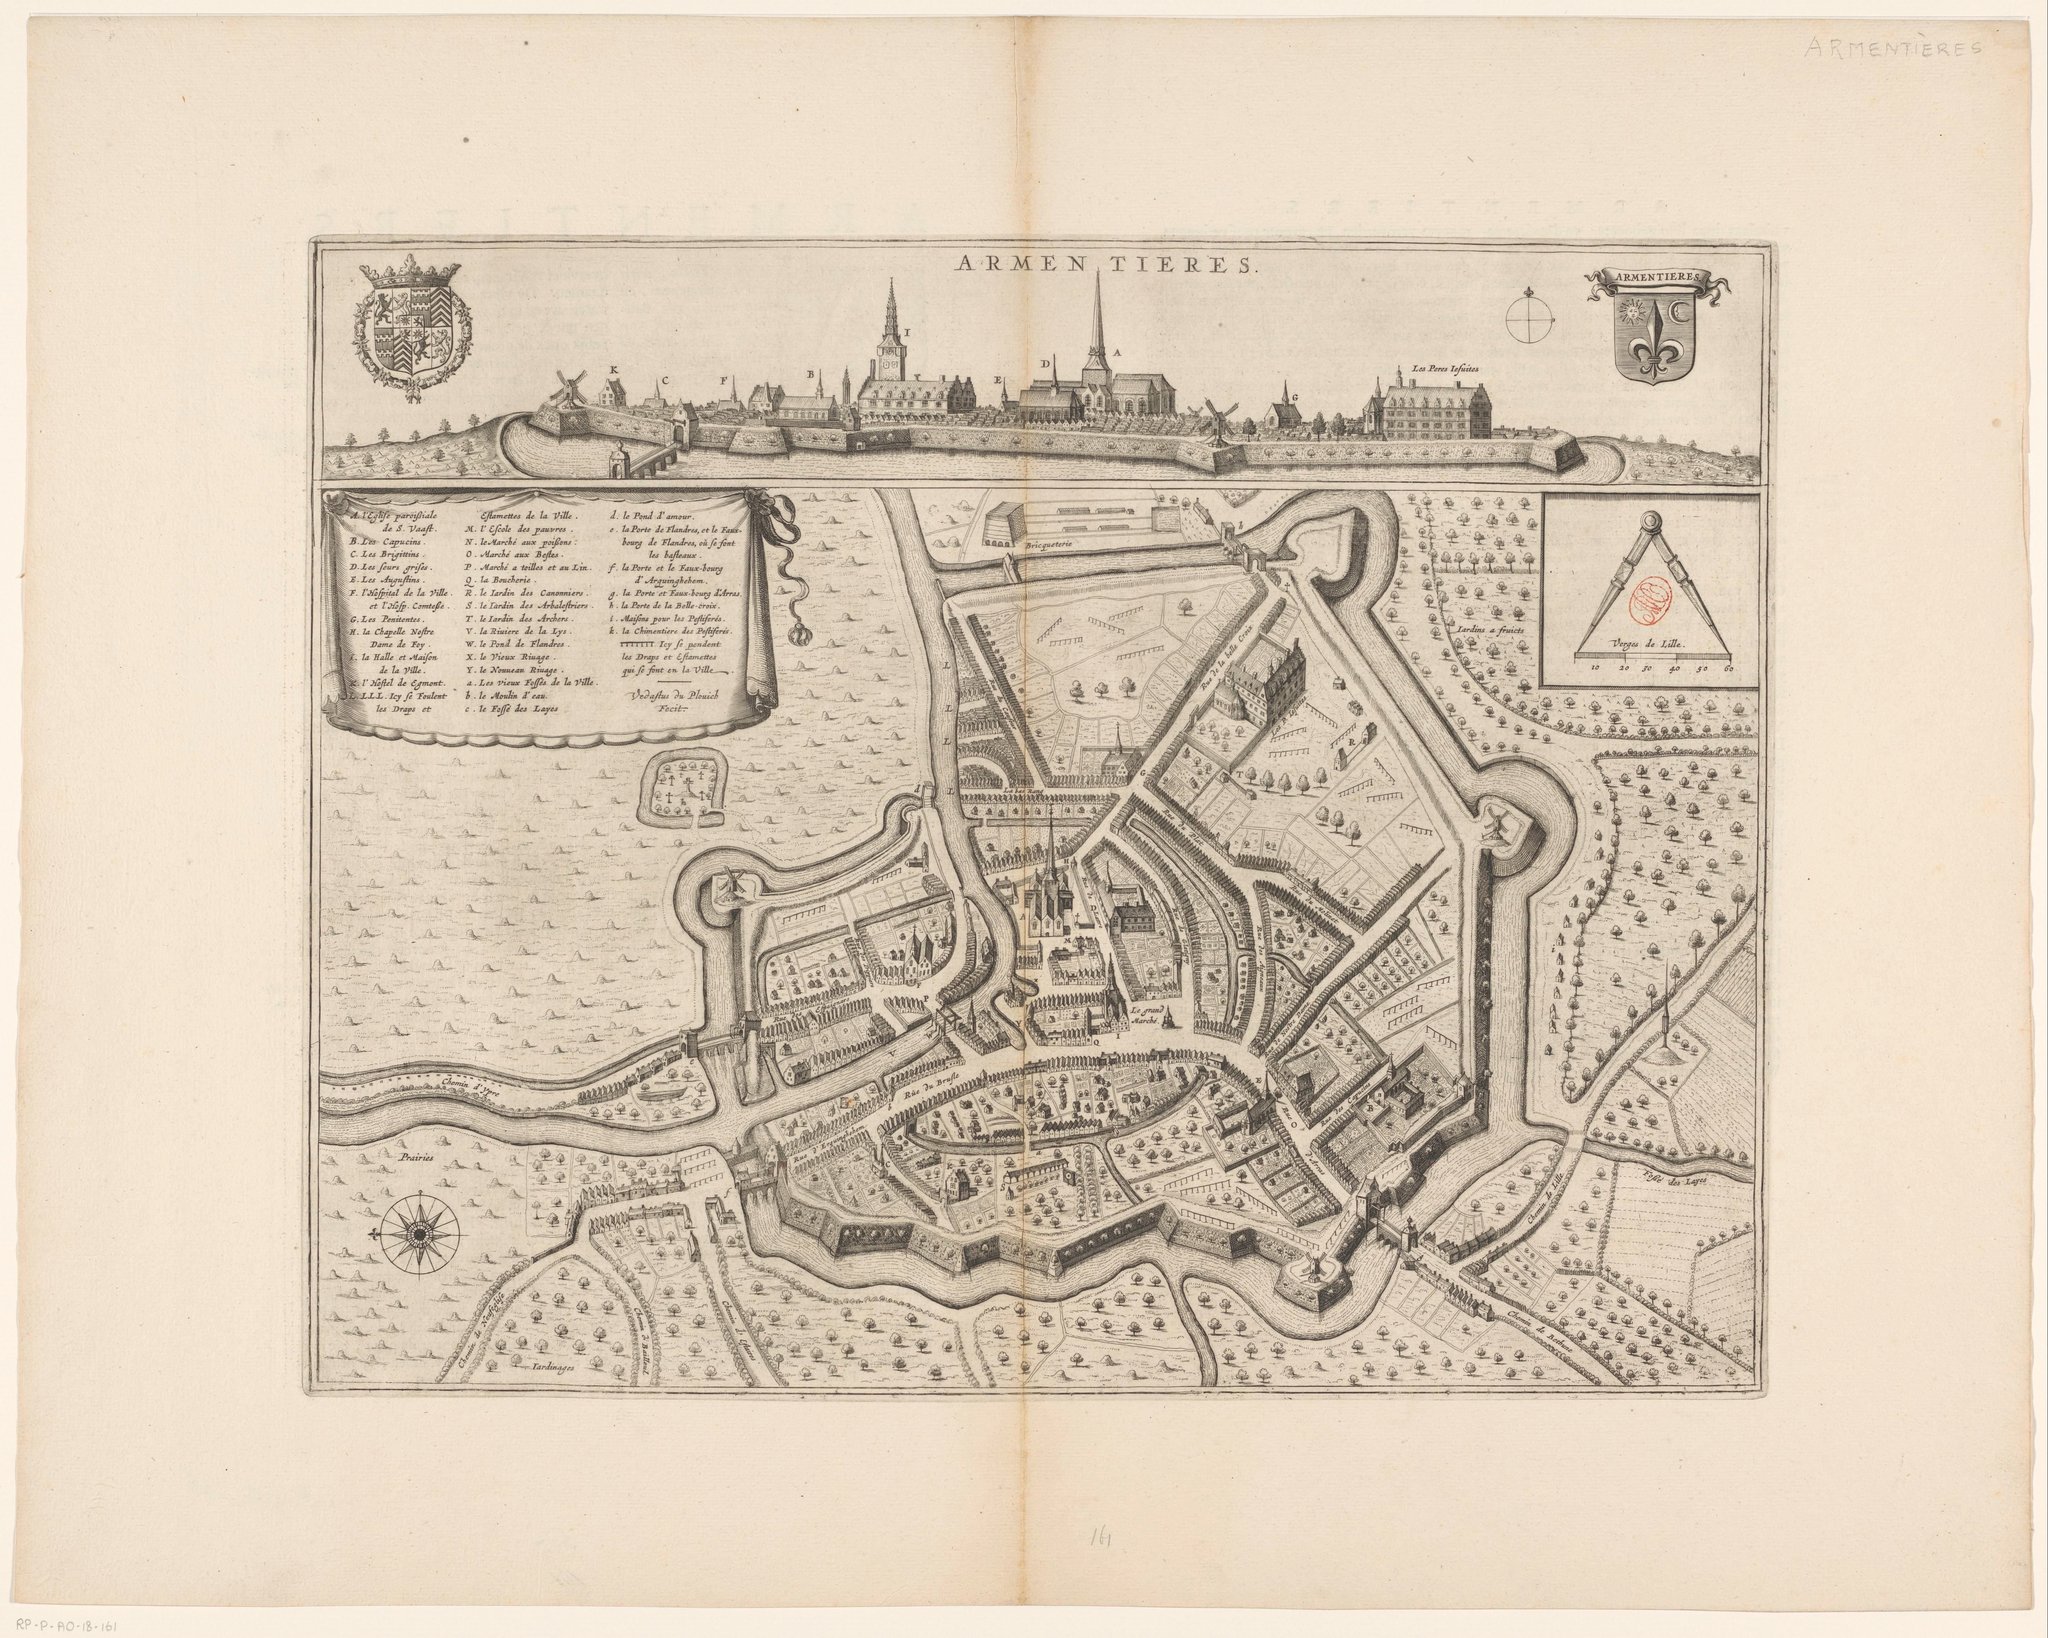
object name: print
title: Plattegrond van en gezicht op Armentiers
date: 1652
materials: paper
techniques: engraving, etching, letterpress printing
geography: amsterdam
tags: prospect of village, silhouette of village, coat of arms (as symbol of the state, etc.) (+ city; municipal), maps of cities, armorial bearing, heraldry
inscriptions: collector's mark: Lugt 2228, collector's mark: Lugt 195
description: Boven een gezicht op Armentiers, met linksboven het wapen van Lamoraal graaf van Egmont en rechtsboven het wapen van Armentiers. Onder een plattegrond van Armentiers met gebouwen in vogelvluchtperspectief. Linksboven een legenda A-Y en a-k. Rechtsboven een kader met een passer en een schaalstok: 60 Verges de Lille. Met Nederlandse tekst op verso.